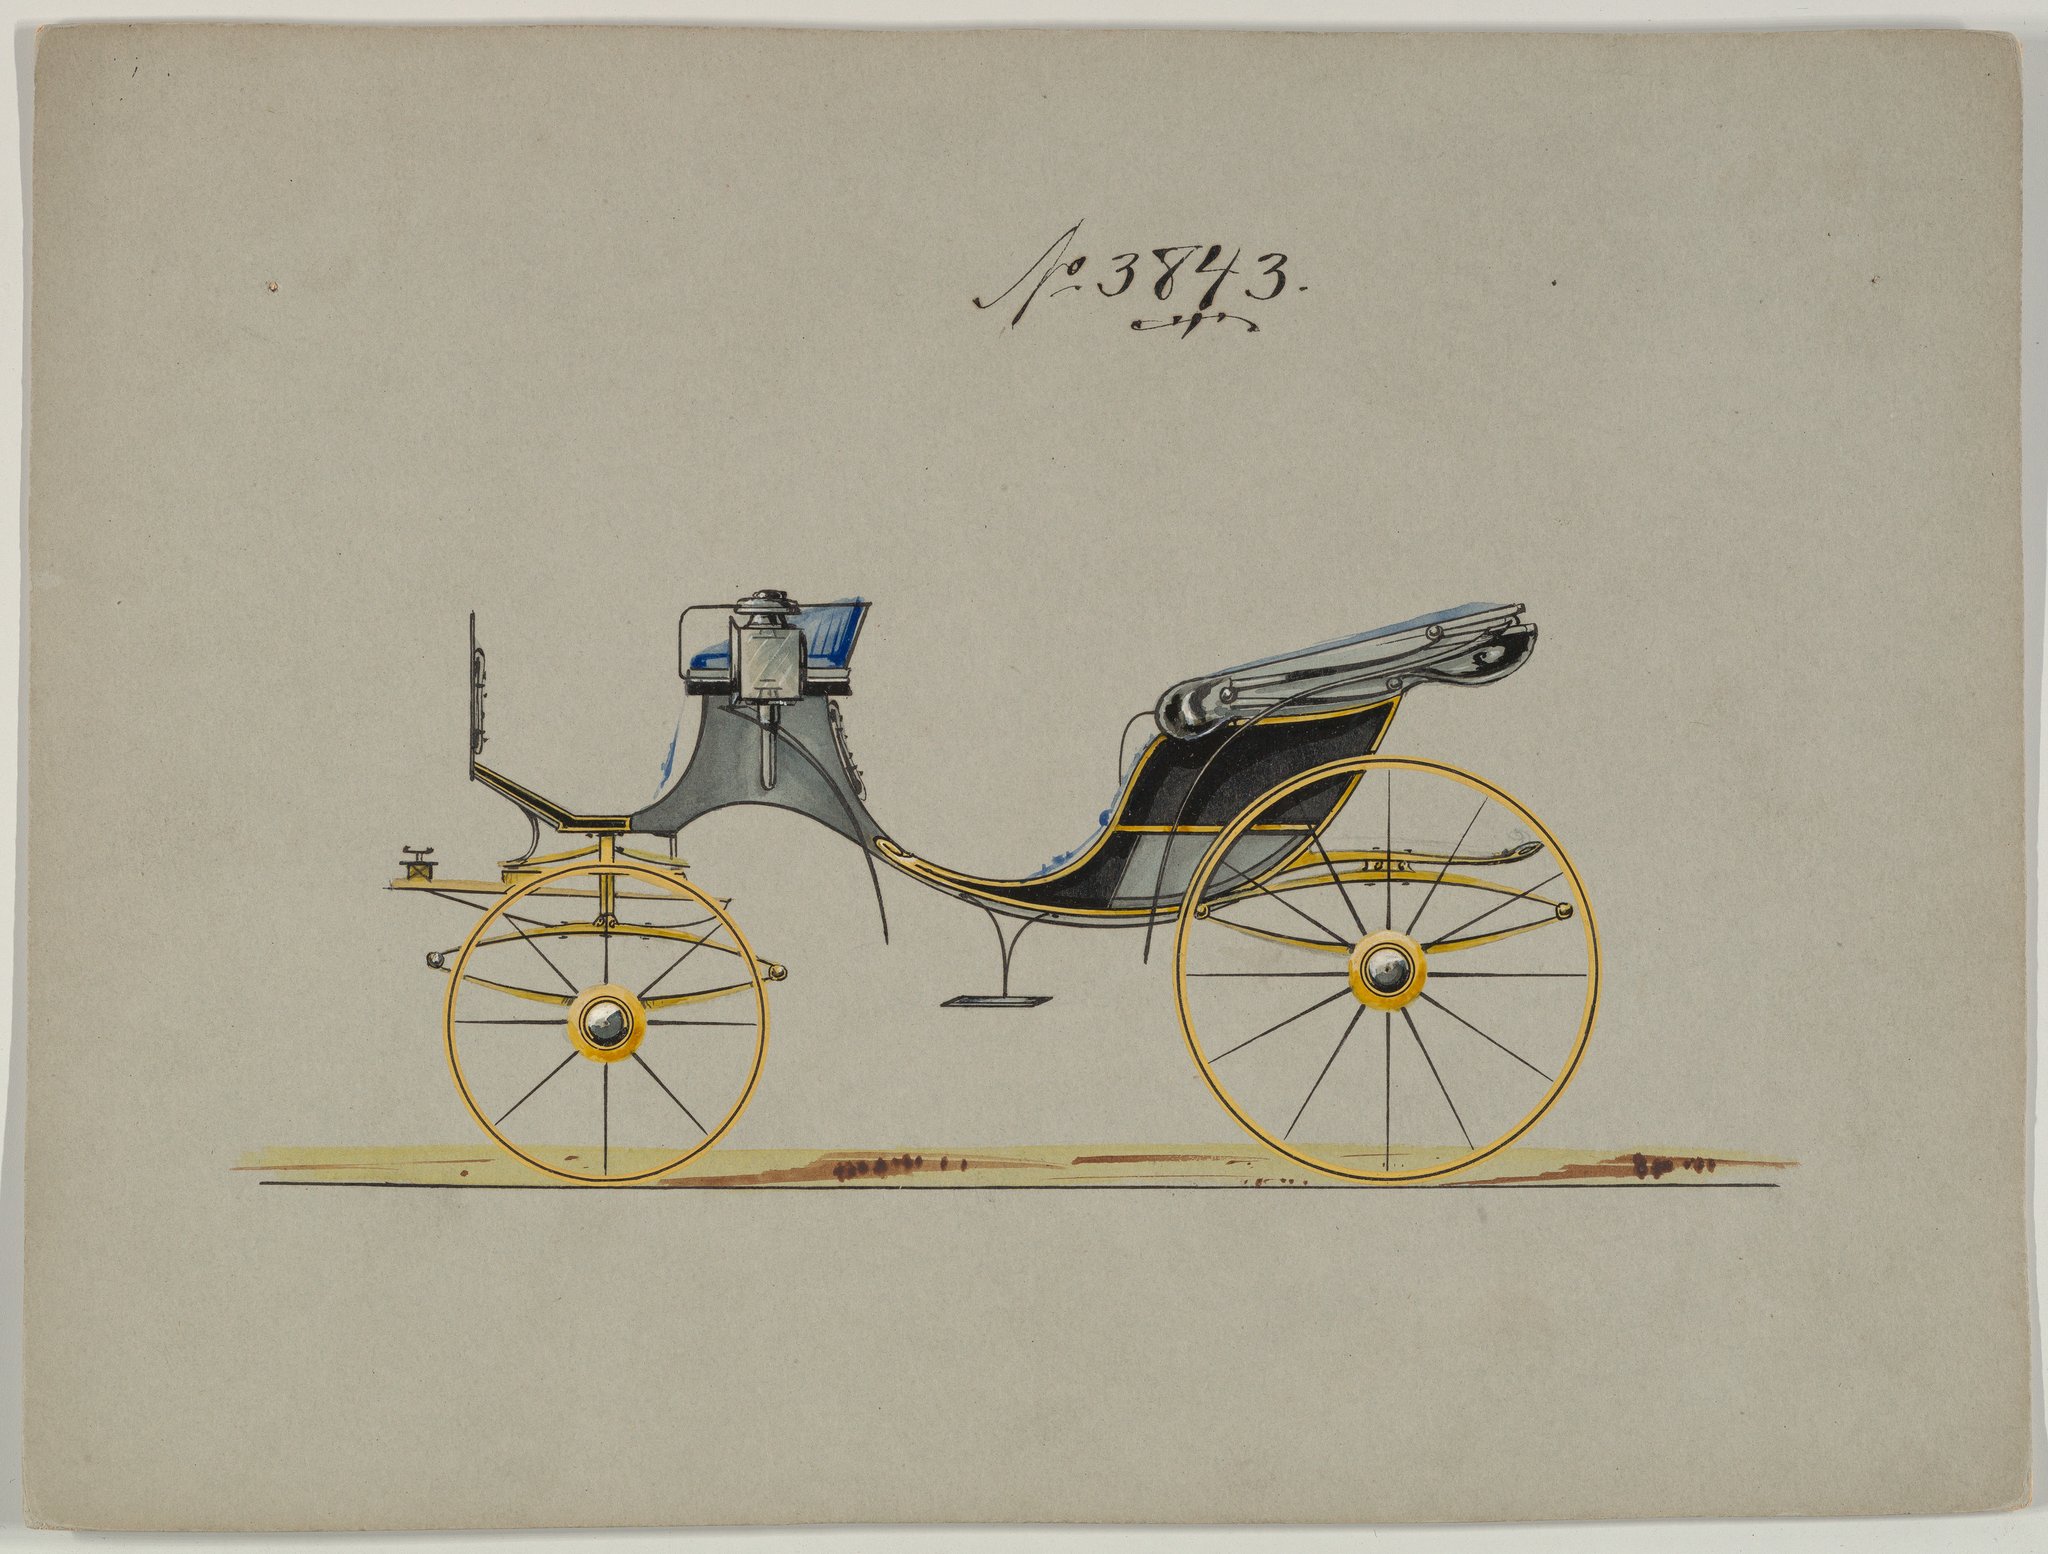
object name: drawing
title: Design for Cabriolet or Victoria, no. 3843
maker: brewster & co.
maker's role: manufacturer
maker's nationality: american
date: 1883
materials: gouache, gum arabic, ink, watercolor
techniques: pen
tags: carriages